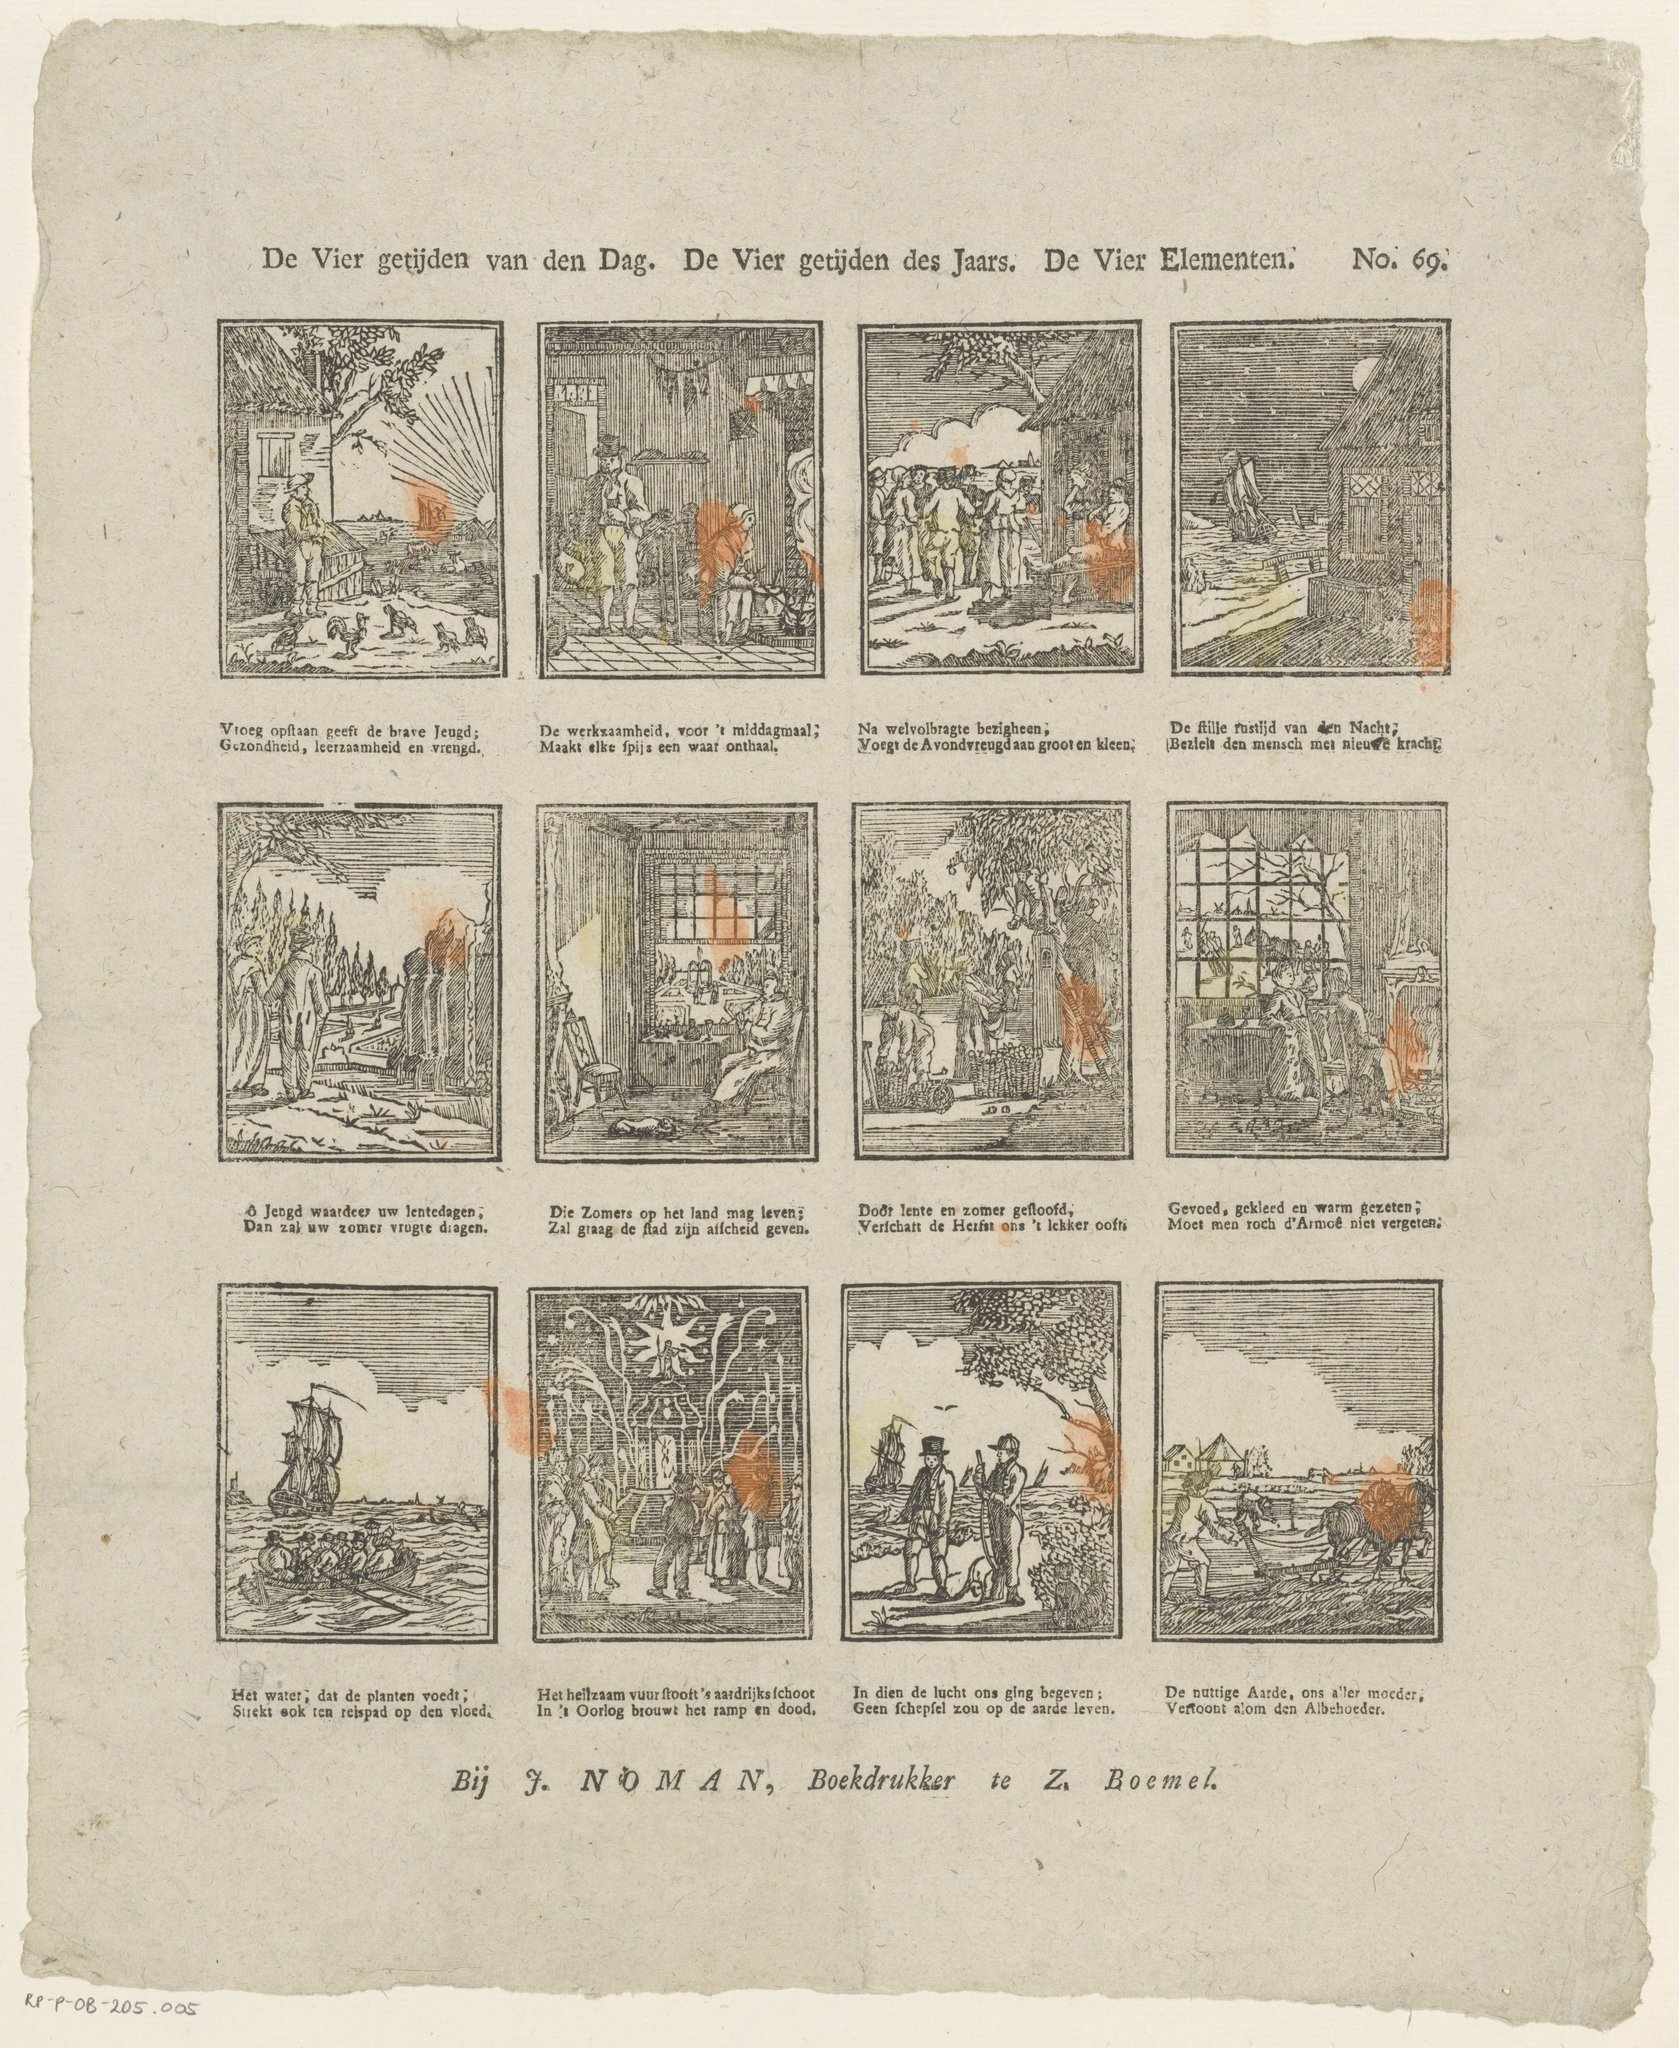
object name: popular print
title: De vier getijden van den dag. / De vier getijden des jaars. / De vier elementen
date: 1806-1830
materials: paper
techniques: colour, letterpress printing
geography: zaltbommel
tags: earth (one of the four elements), water (one of the four elements), fire (one of the four elements), air (one of the four elements), evening, morning, day and night, afternoon, night, the four seasons of the year ~ human activities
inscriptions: collector's mark: Lugt 2760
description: Blad met 12 voorstellingen van de vier delen van de dag (ochtend, middag, avond, nacht), de vier jaargetijden (lente, zomer, herst, winter) en de vier elementen (water, vuur, lucht, aarde). Onder elke afbeelding een tweeregelig vers. Genummerd rechtsboven: No. 69.